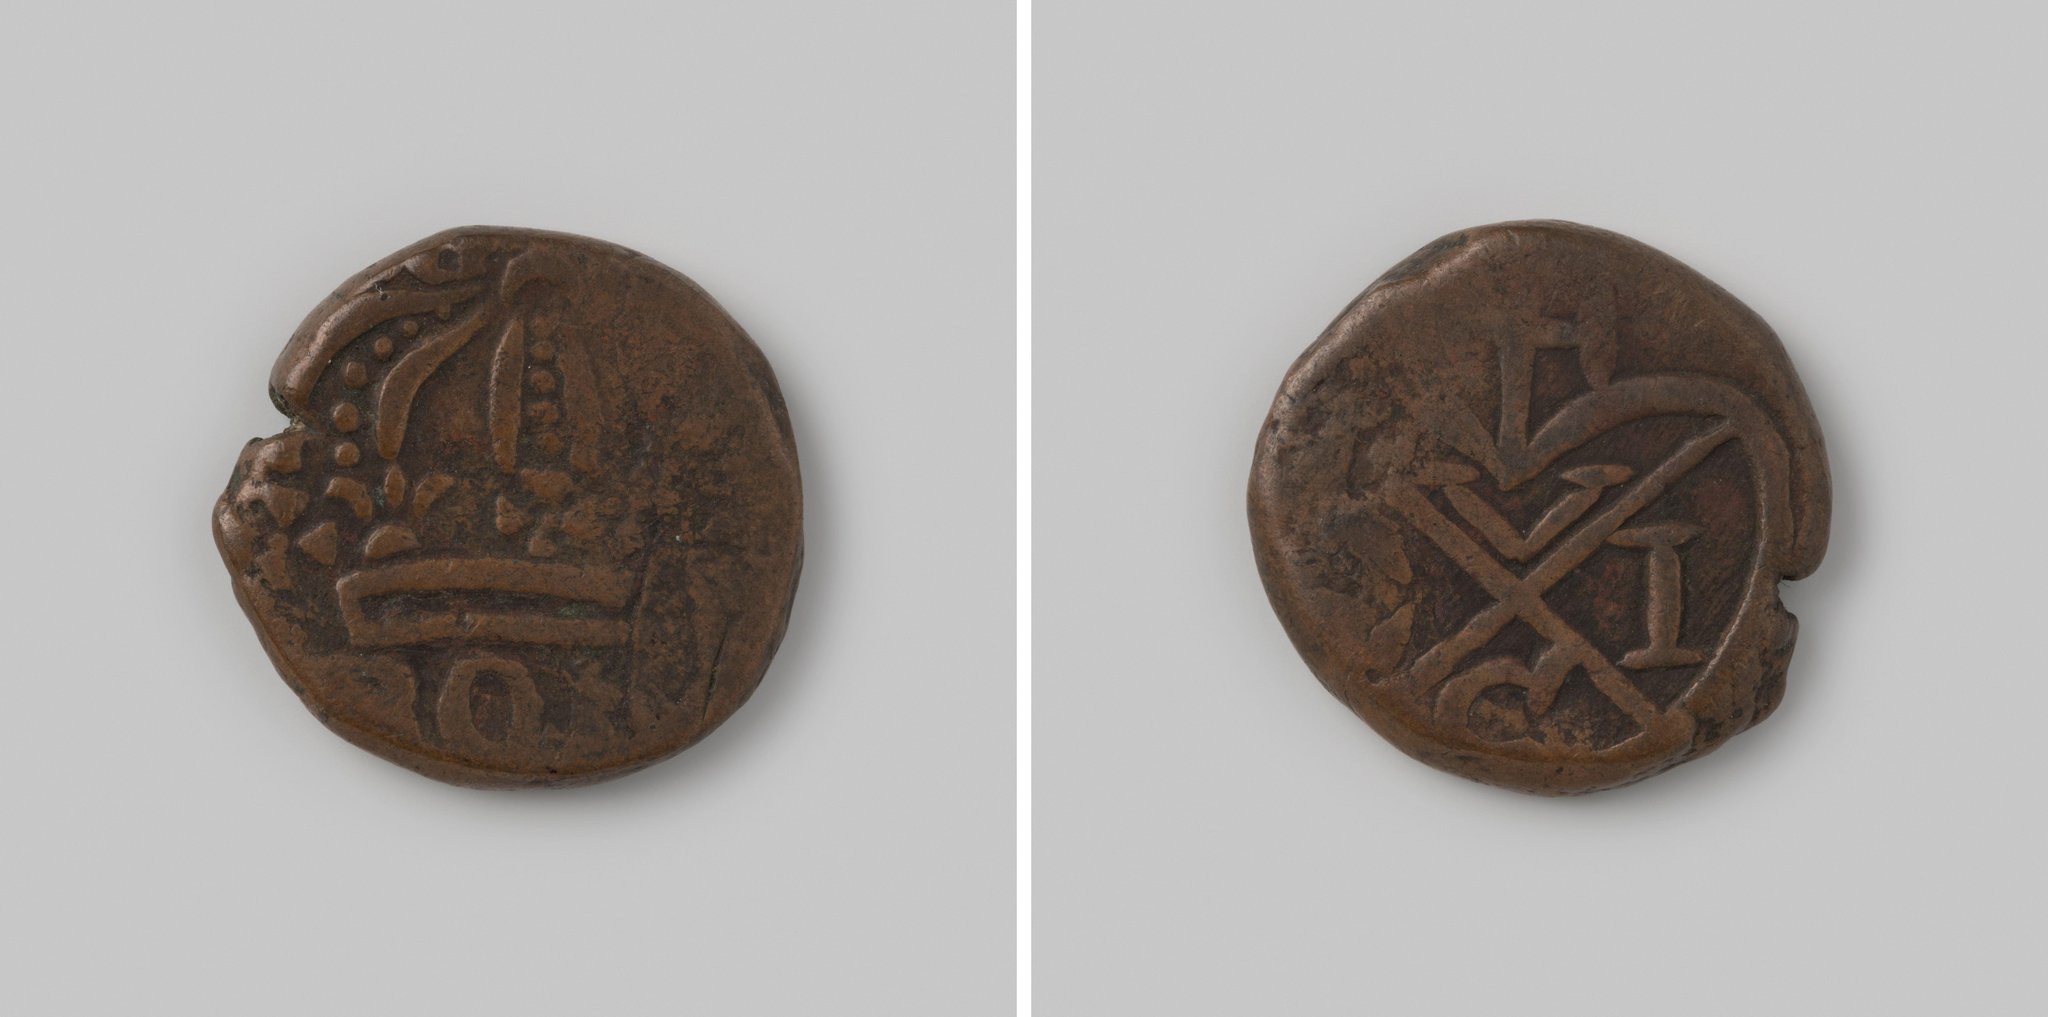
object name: coin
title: Pice uit Bombay in India van de Engelse Oostindische Compagnie (EIC) tijdens George I, 1714-1727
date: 1714-1727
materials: copper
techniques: striking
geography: mumbai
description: Koperen munt. Voorzijde: kroon. Daarboven letters G en R en daaronder in een regel aanduiding plaats: BOM [=Bombay]. Keerzijde: merk van de EIC.